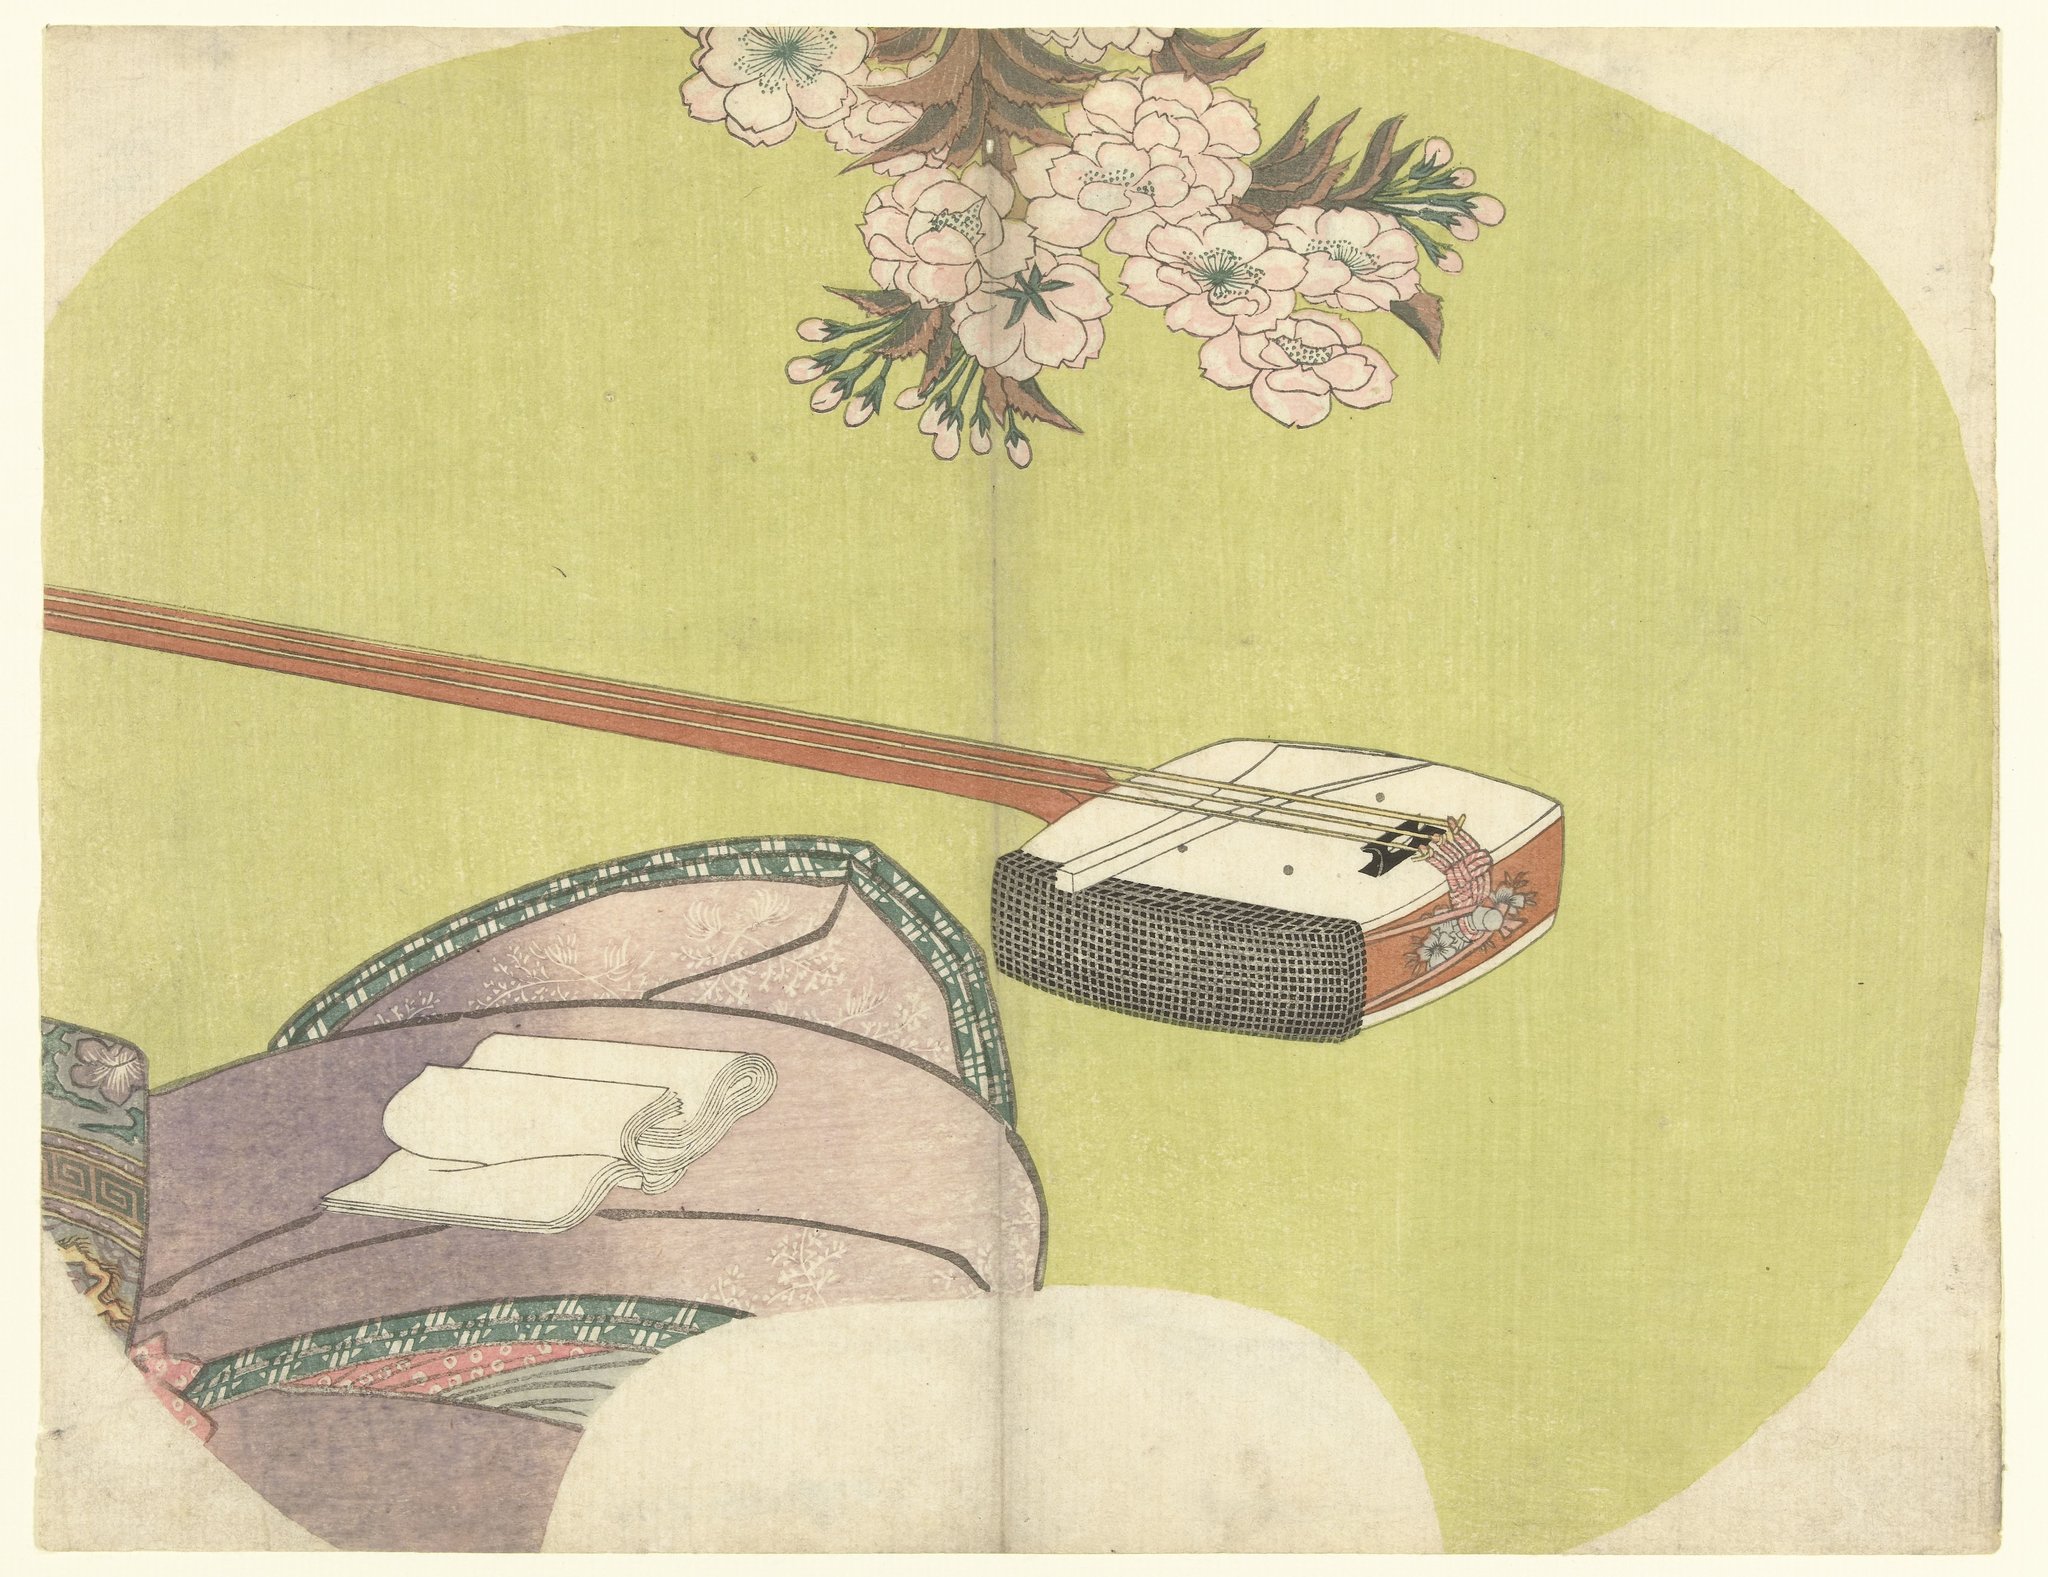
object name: print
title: De moderne twaalf maanden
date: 1822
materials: paper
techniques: woodcut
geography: japan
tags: courtesan, hetaera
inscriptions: date